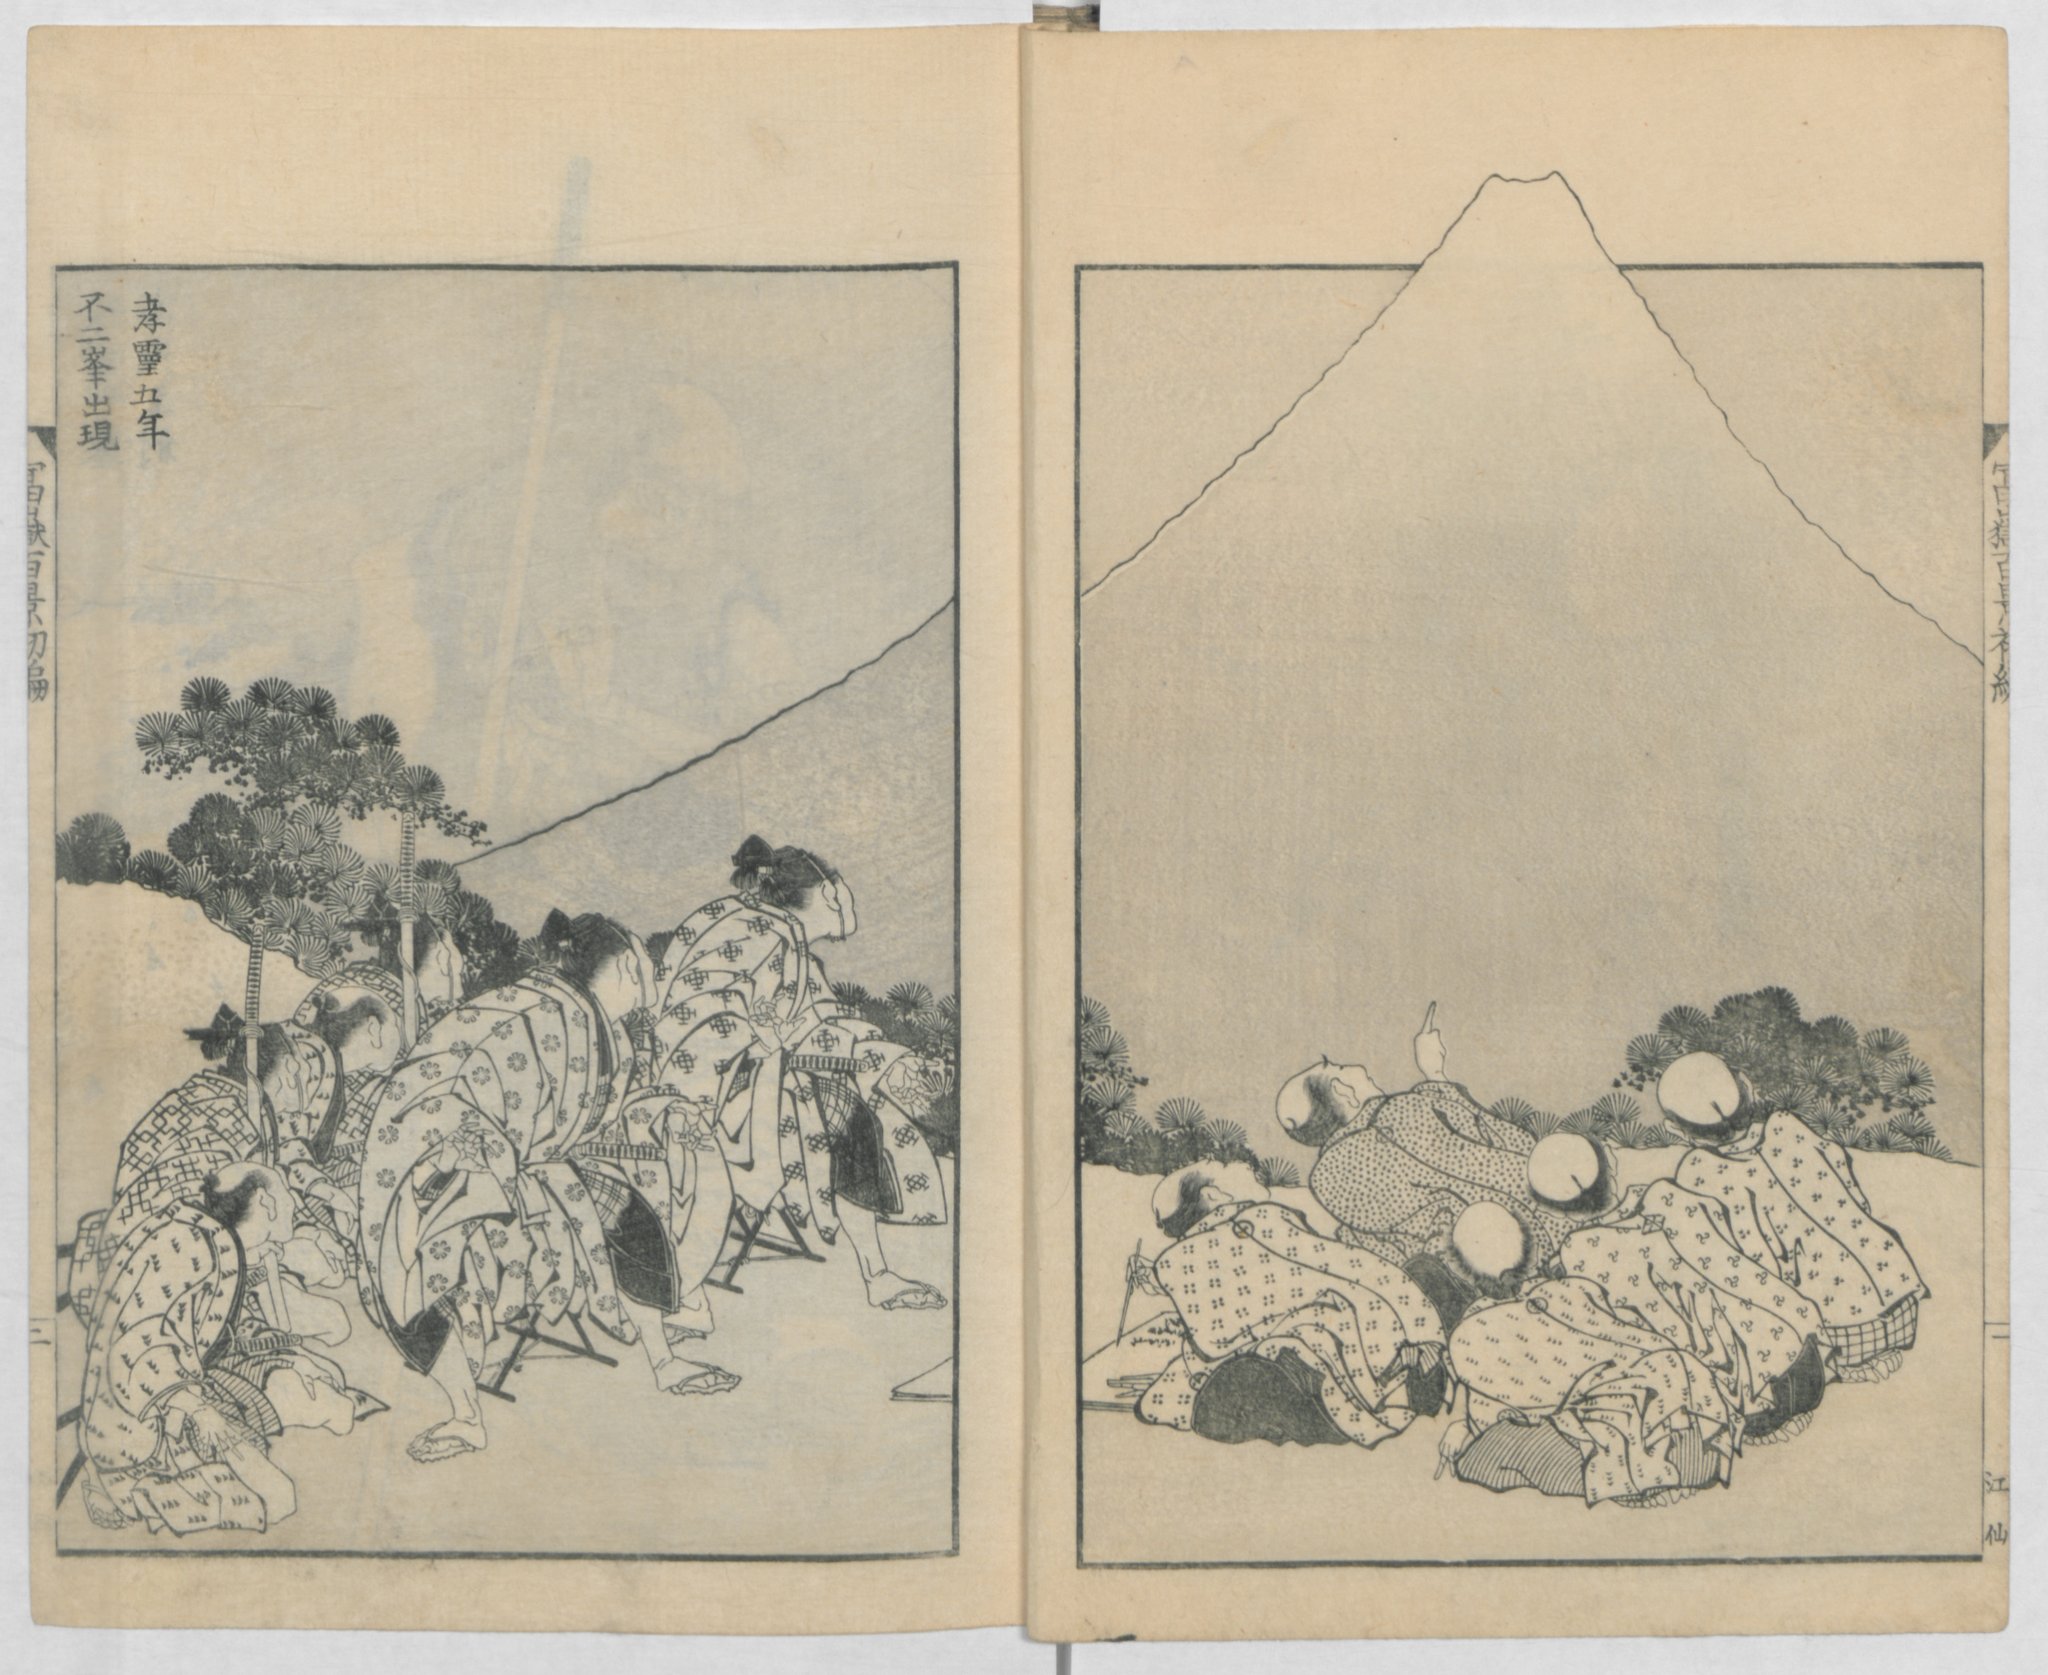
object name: illustrated book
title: One Hundred Views of Mount Fuji (Fugaku hyakkei, nihen) 富嶽百景二編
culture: japanese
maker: katsushika hokusai 葛飾北斎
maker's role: artist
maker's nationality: japanese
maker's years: 1760-1849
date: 1834-1835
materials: ink, paper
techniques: woodblock print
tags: men,volcanoes,trees